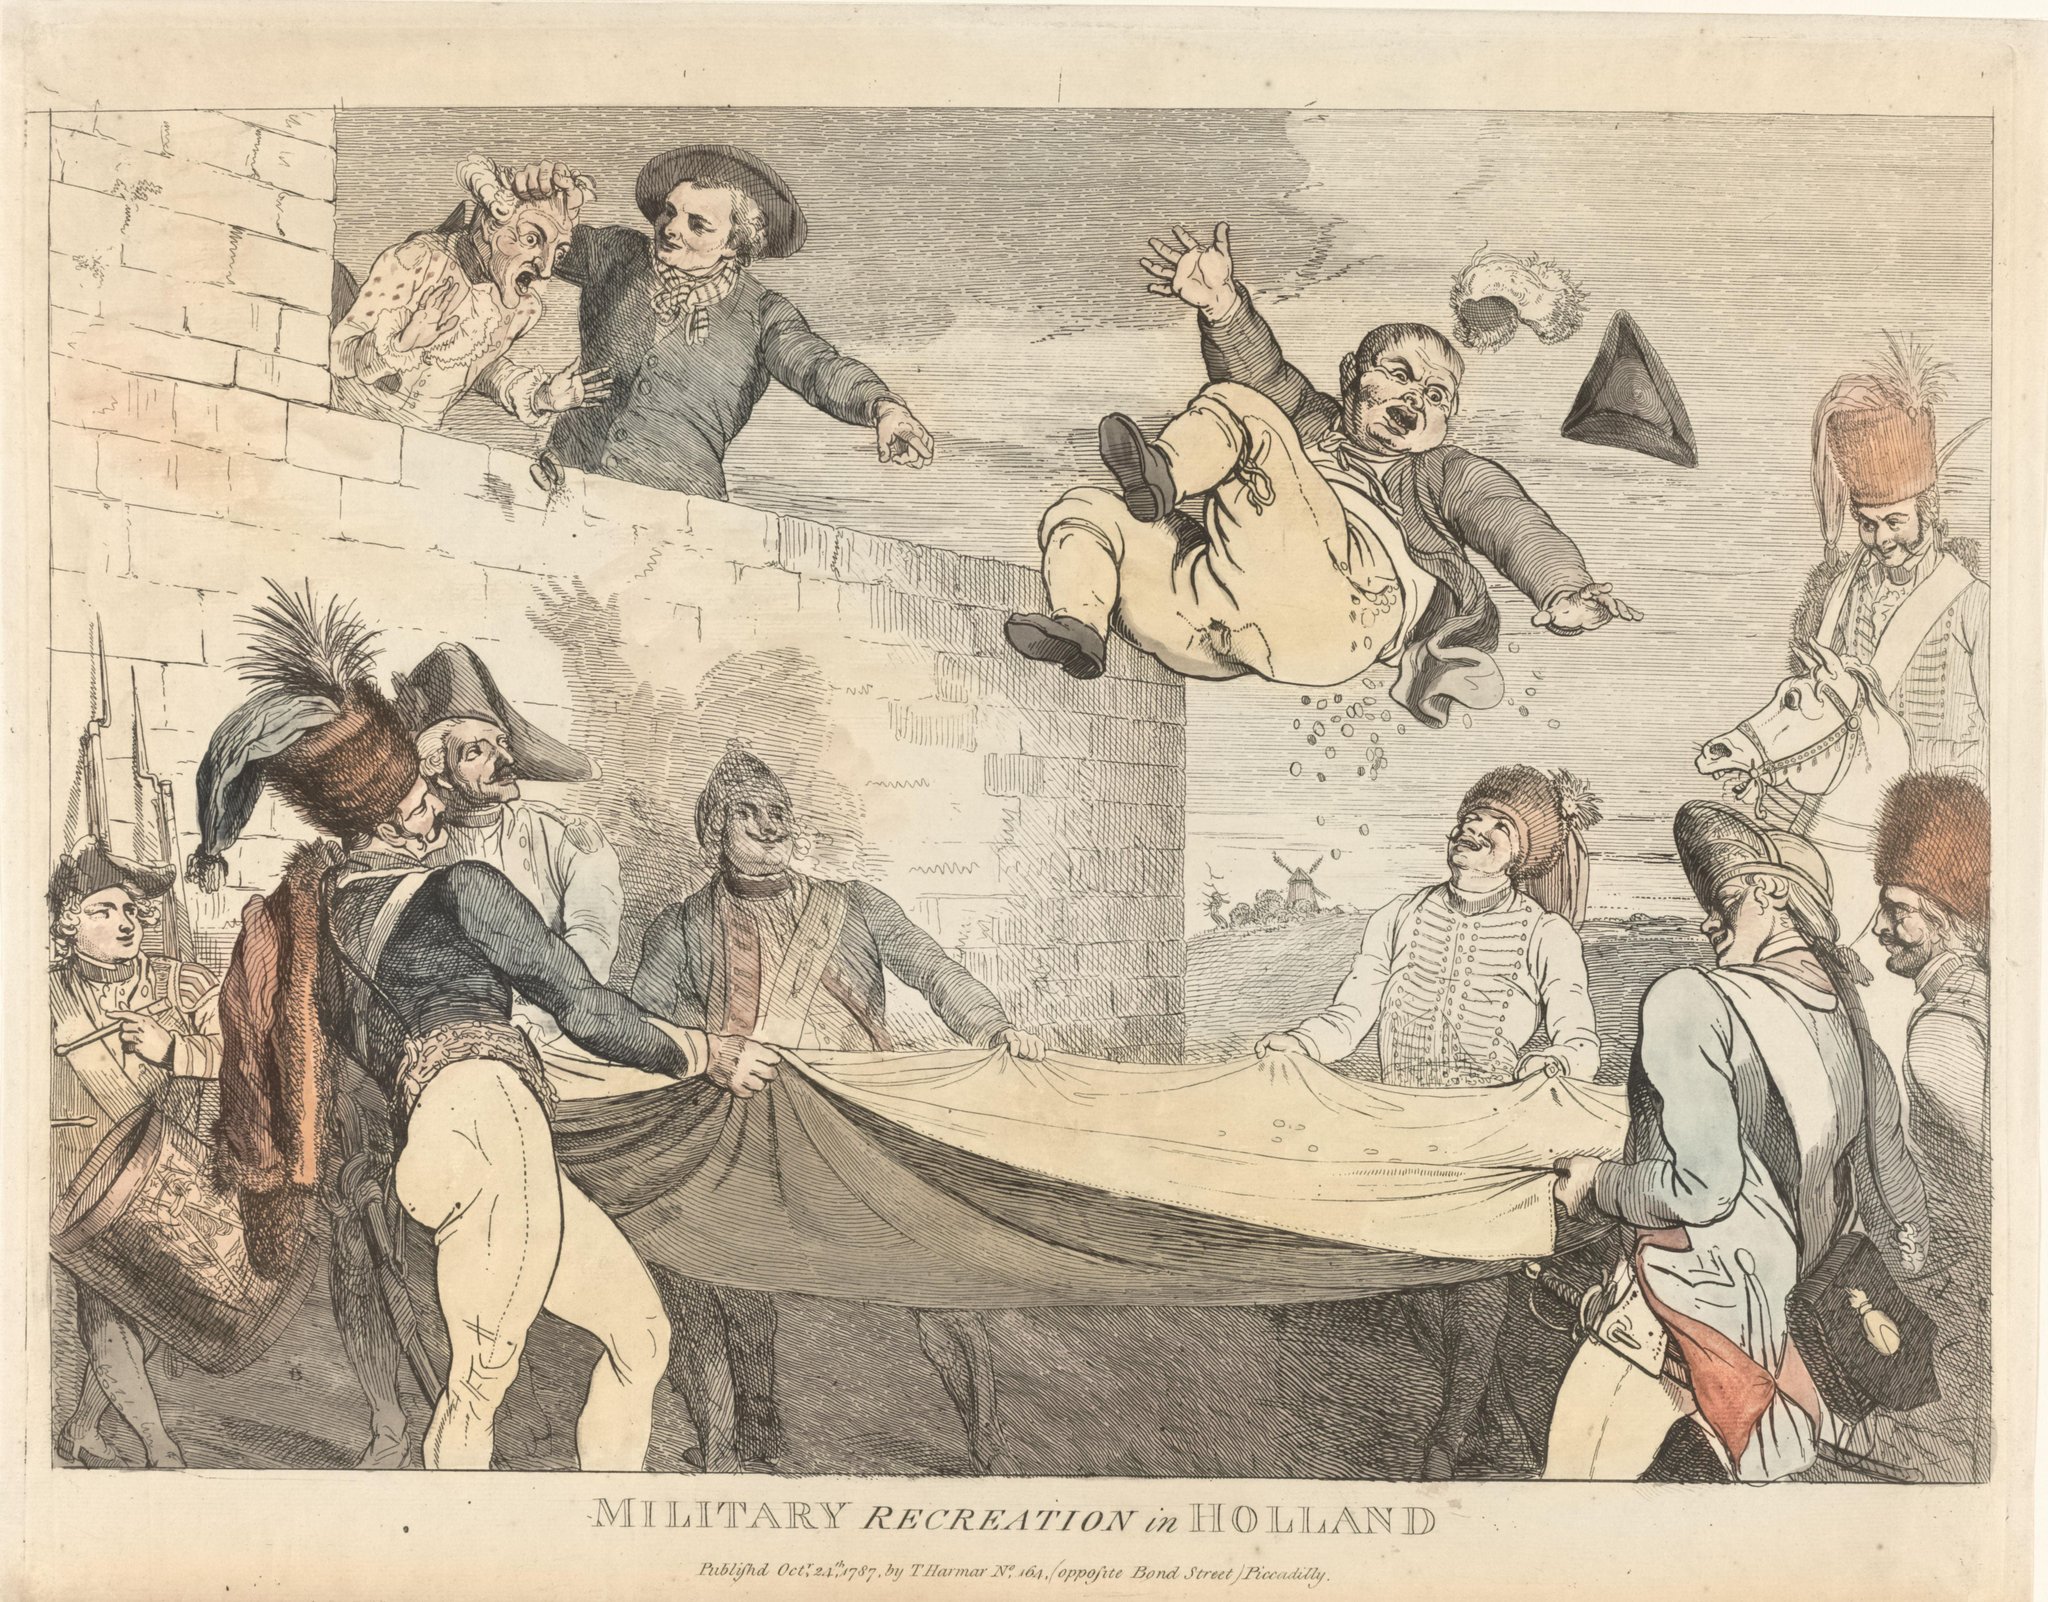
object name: print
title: Patriotse hemelvaart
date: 1787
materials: paper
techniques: etching, hand coloring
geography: london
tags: grown-ups playing children's games, patriots (1780-1795)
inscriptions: collector's mark: Lugt 2228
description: Een Hollandse patriot wordt door Pruisische soldaten in een deken in de lucht gegooid, waardoor de geldstukken uit zijn zakken vliegen. Linksboven dwingt een Engelse matroos de Fransman toe te kijken. Pastiche op een illustratie van een episode uit de avonturen van Don Quichot en Sancho Panza. Onderdeel van een groep van vier spotprenten op de patriotten ten tijde van de Pruisische inval in oktober 1787. De De originele versie met Engelse opschriften uitgegeven in Londen. Zie ook de pendant en het bijbehorende paar spotprenten.